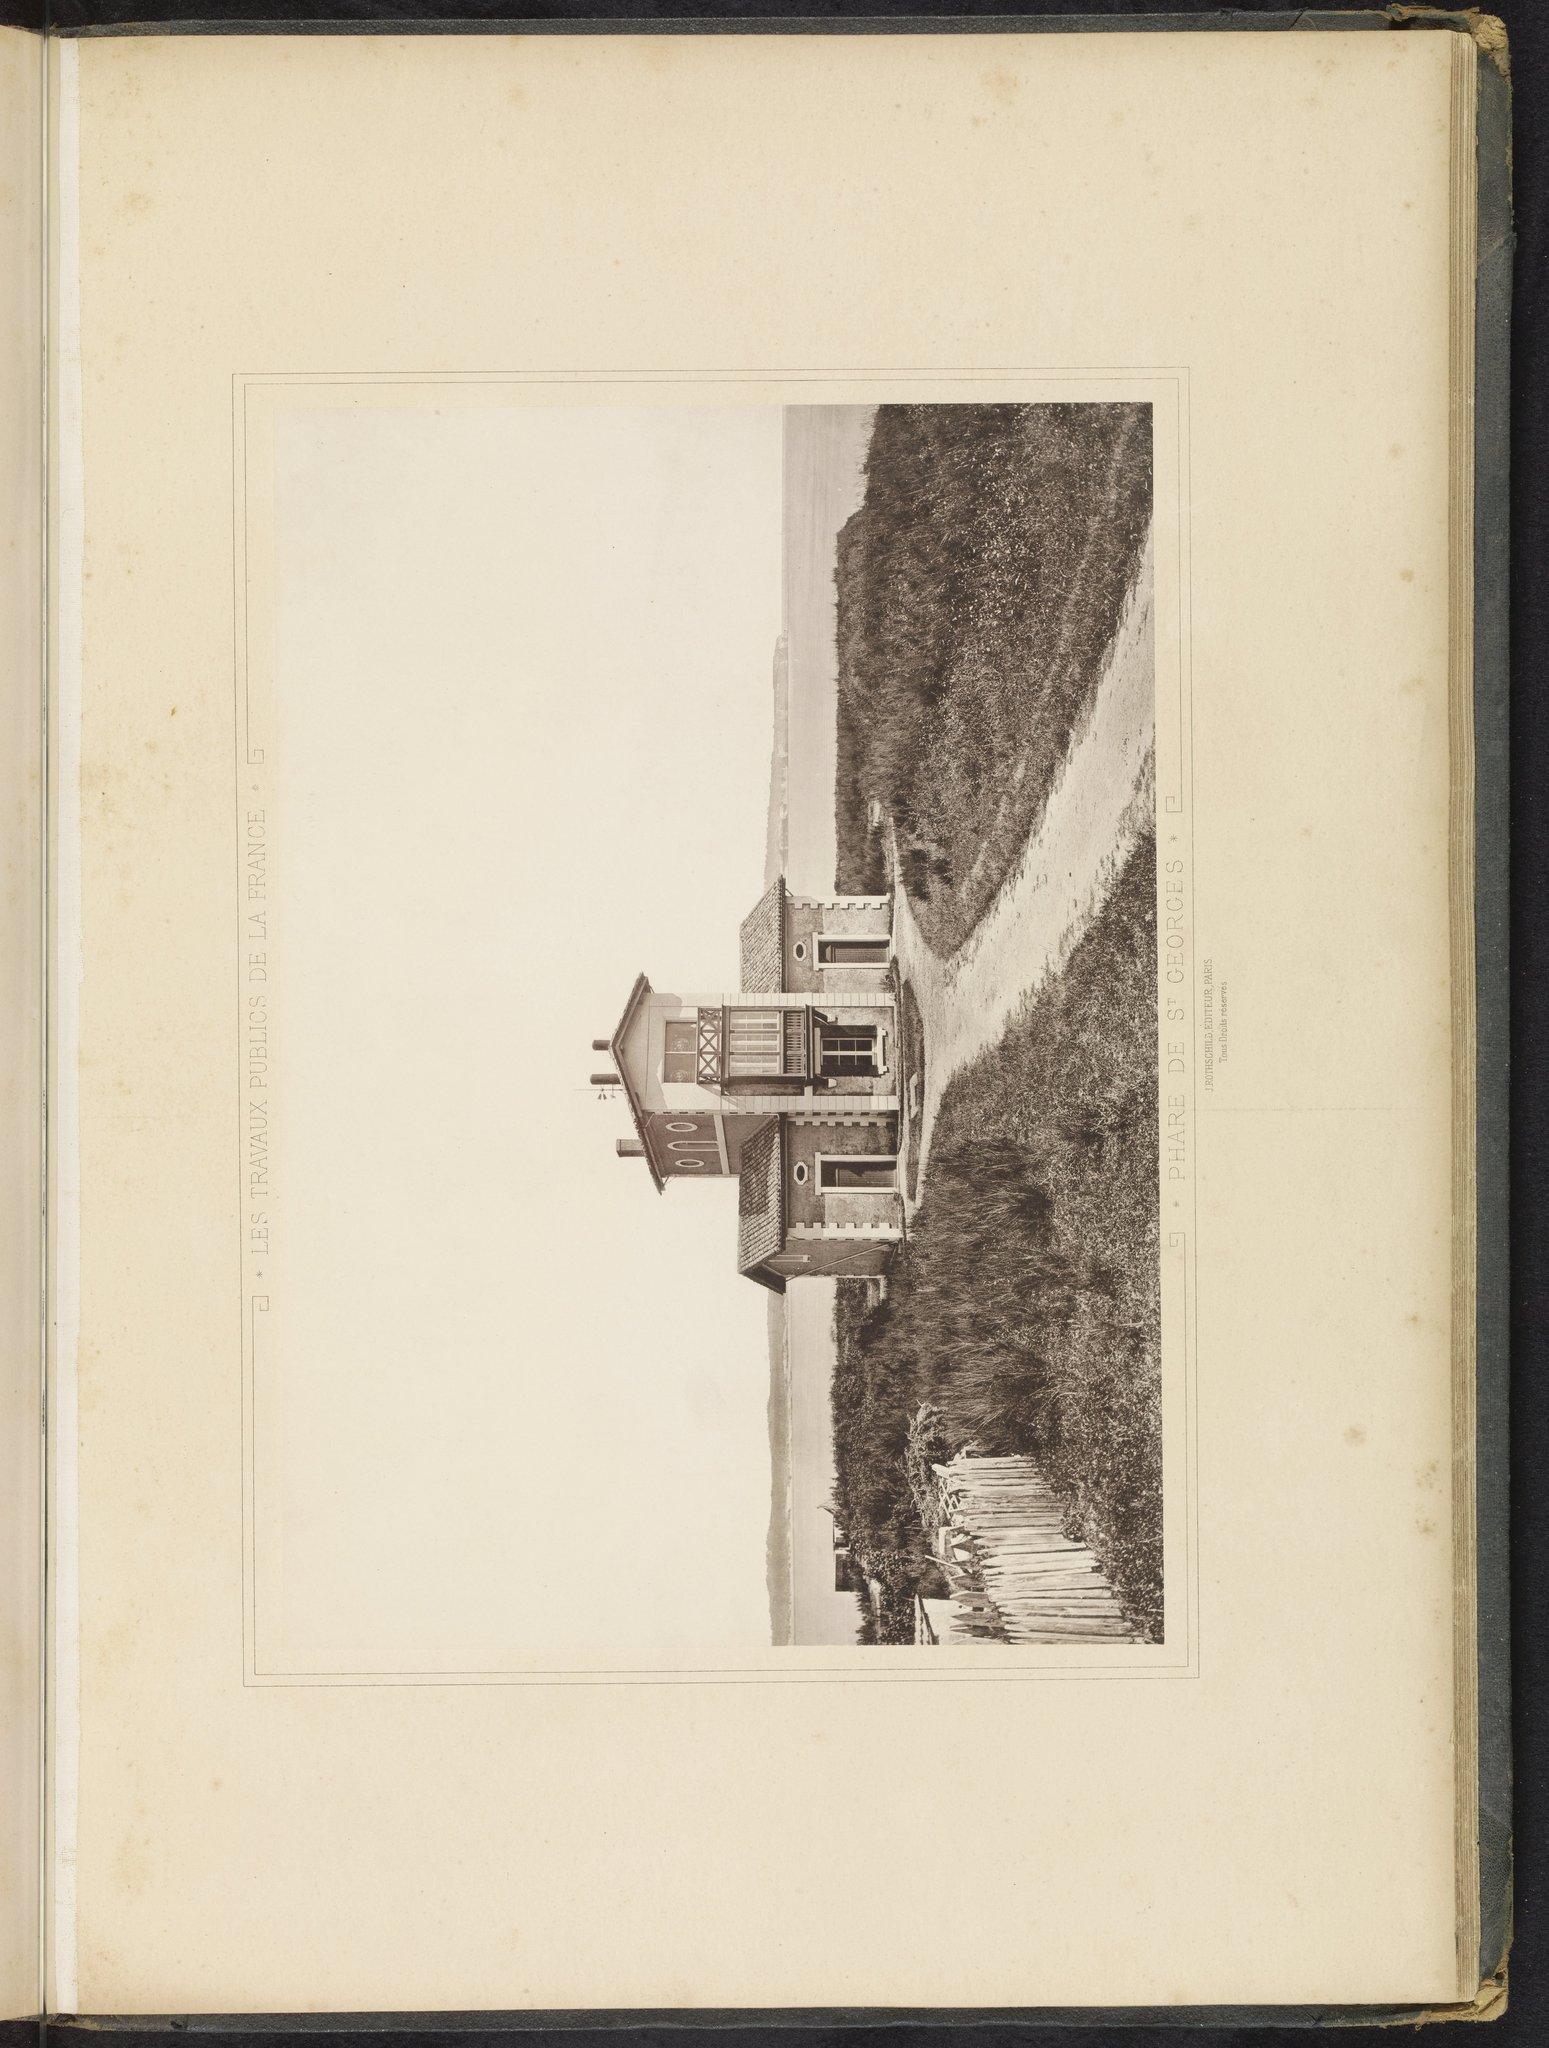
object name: photomechanical print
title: Phare du St Georges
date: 1873-1883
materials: paper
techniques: photograph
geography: france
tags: lighthouse, lightship